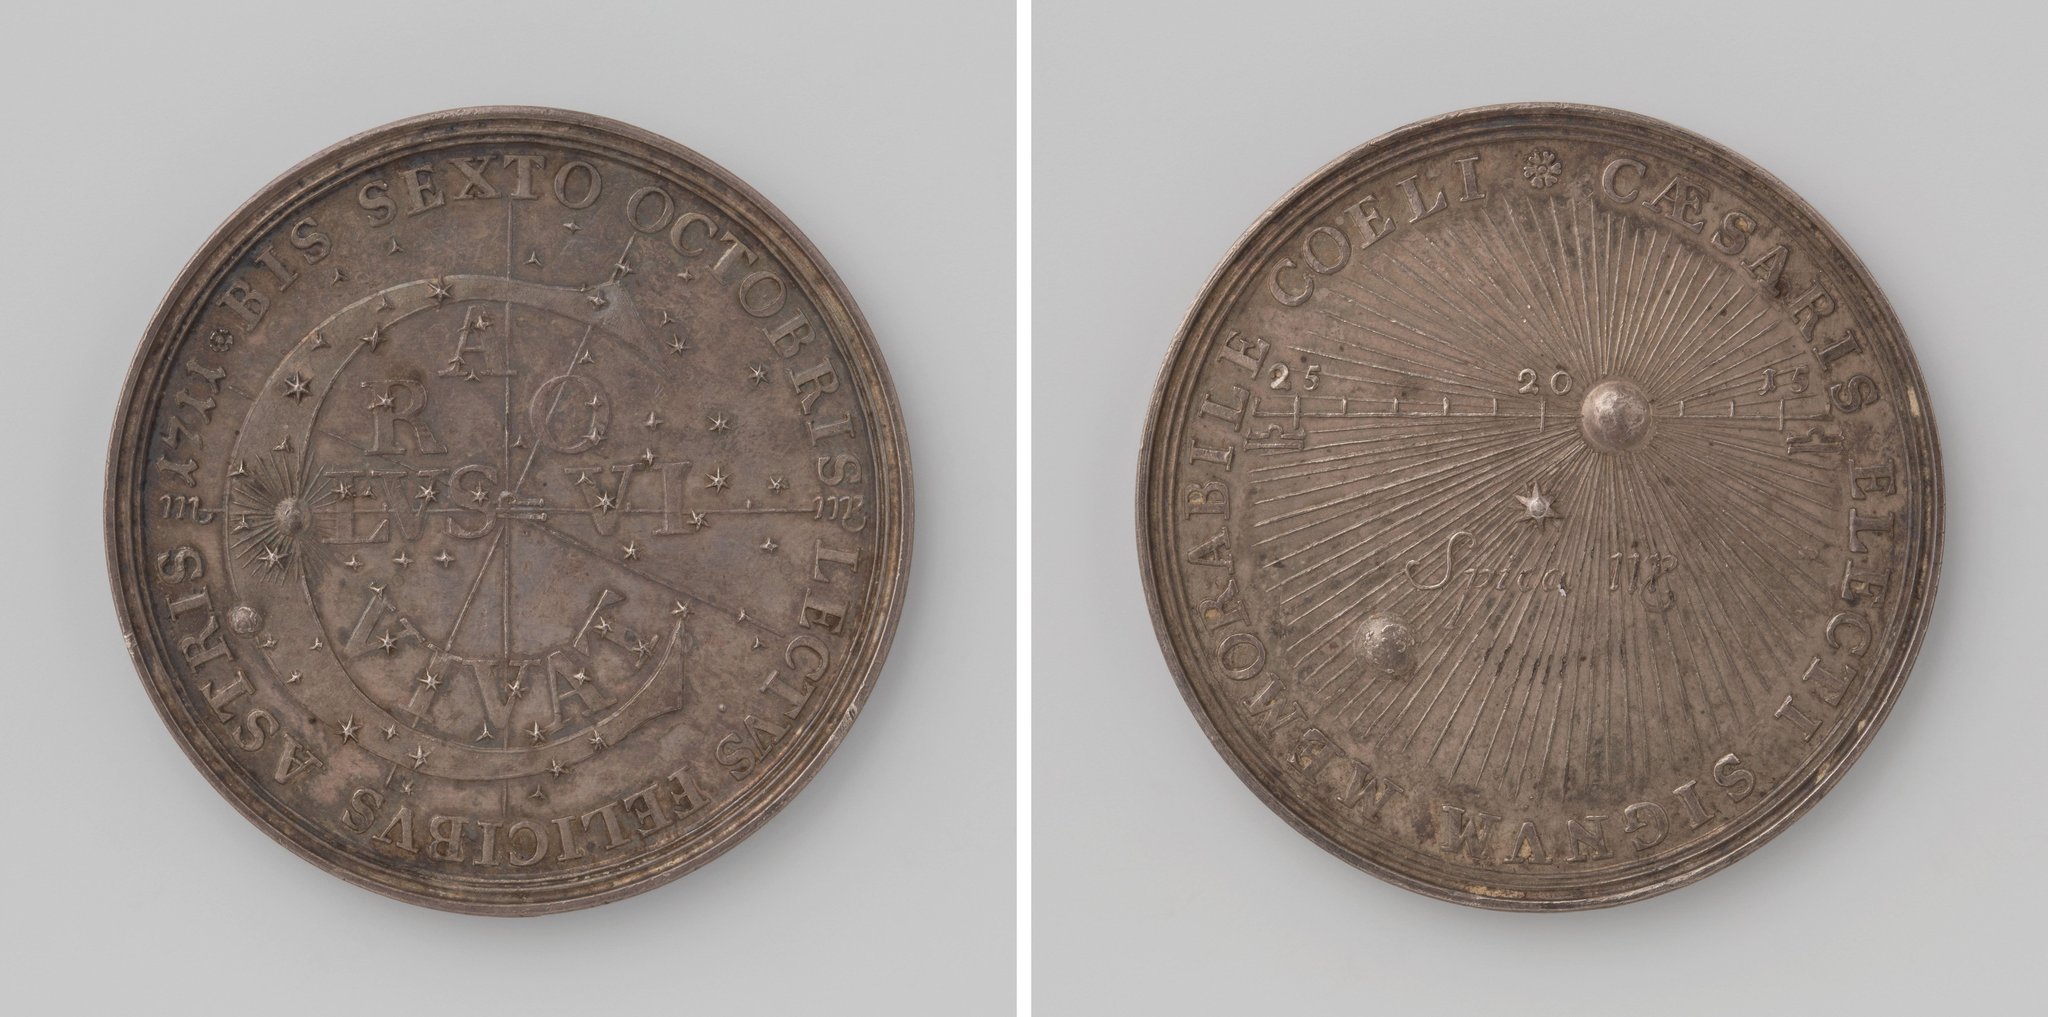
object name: history medal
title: Karel VI gekozen tot Duits keizer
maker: Anonymous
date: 1711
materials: silver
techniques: striking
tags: vienna, charles vi (holy roman emperor)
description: Zilveren penning. Voorzijde: stand der sterren op het moment van de verkiezing van Karel tot keizer, daartussen door letters van zijn naam binnen omschrift. Keerzijde: stand van de zon tijdens de verkiezing van Karel binnen omschrift